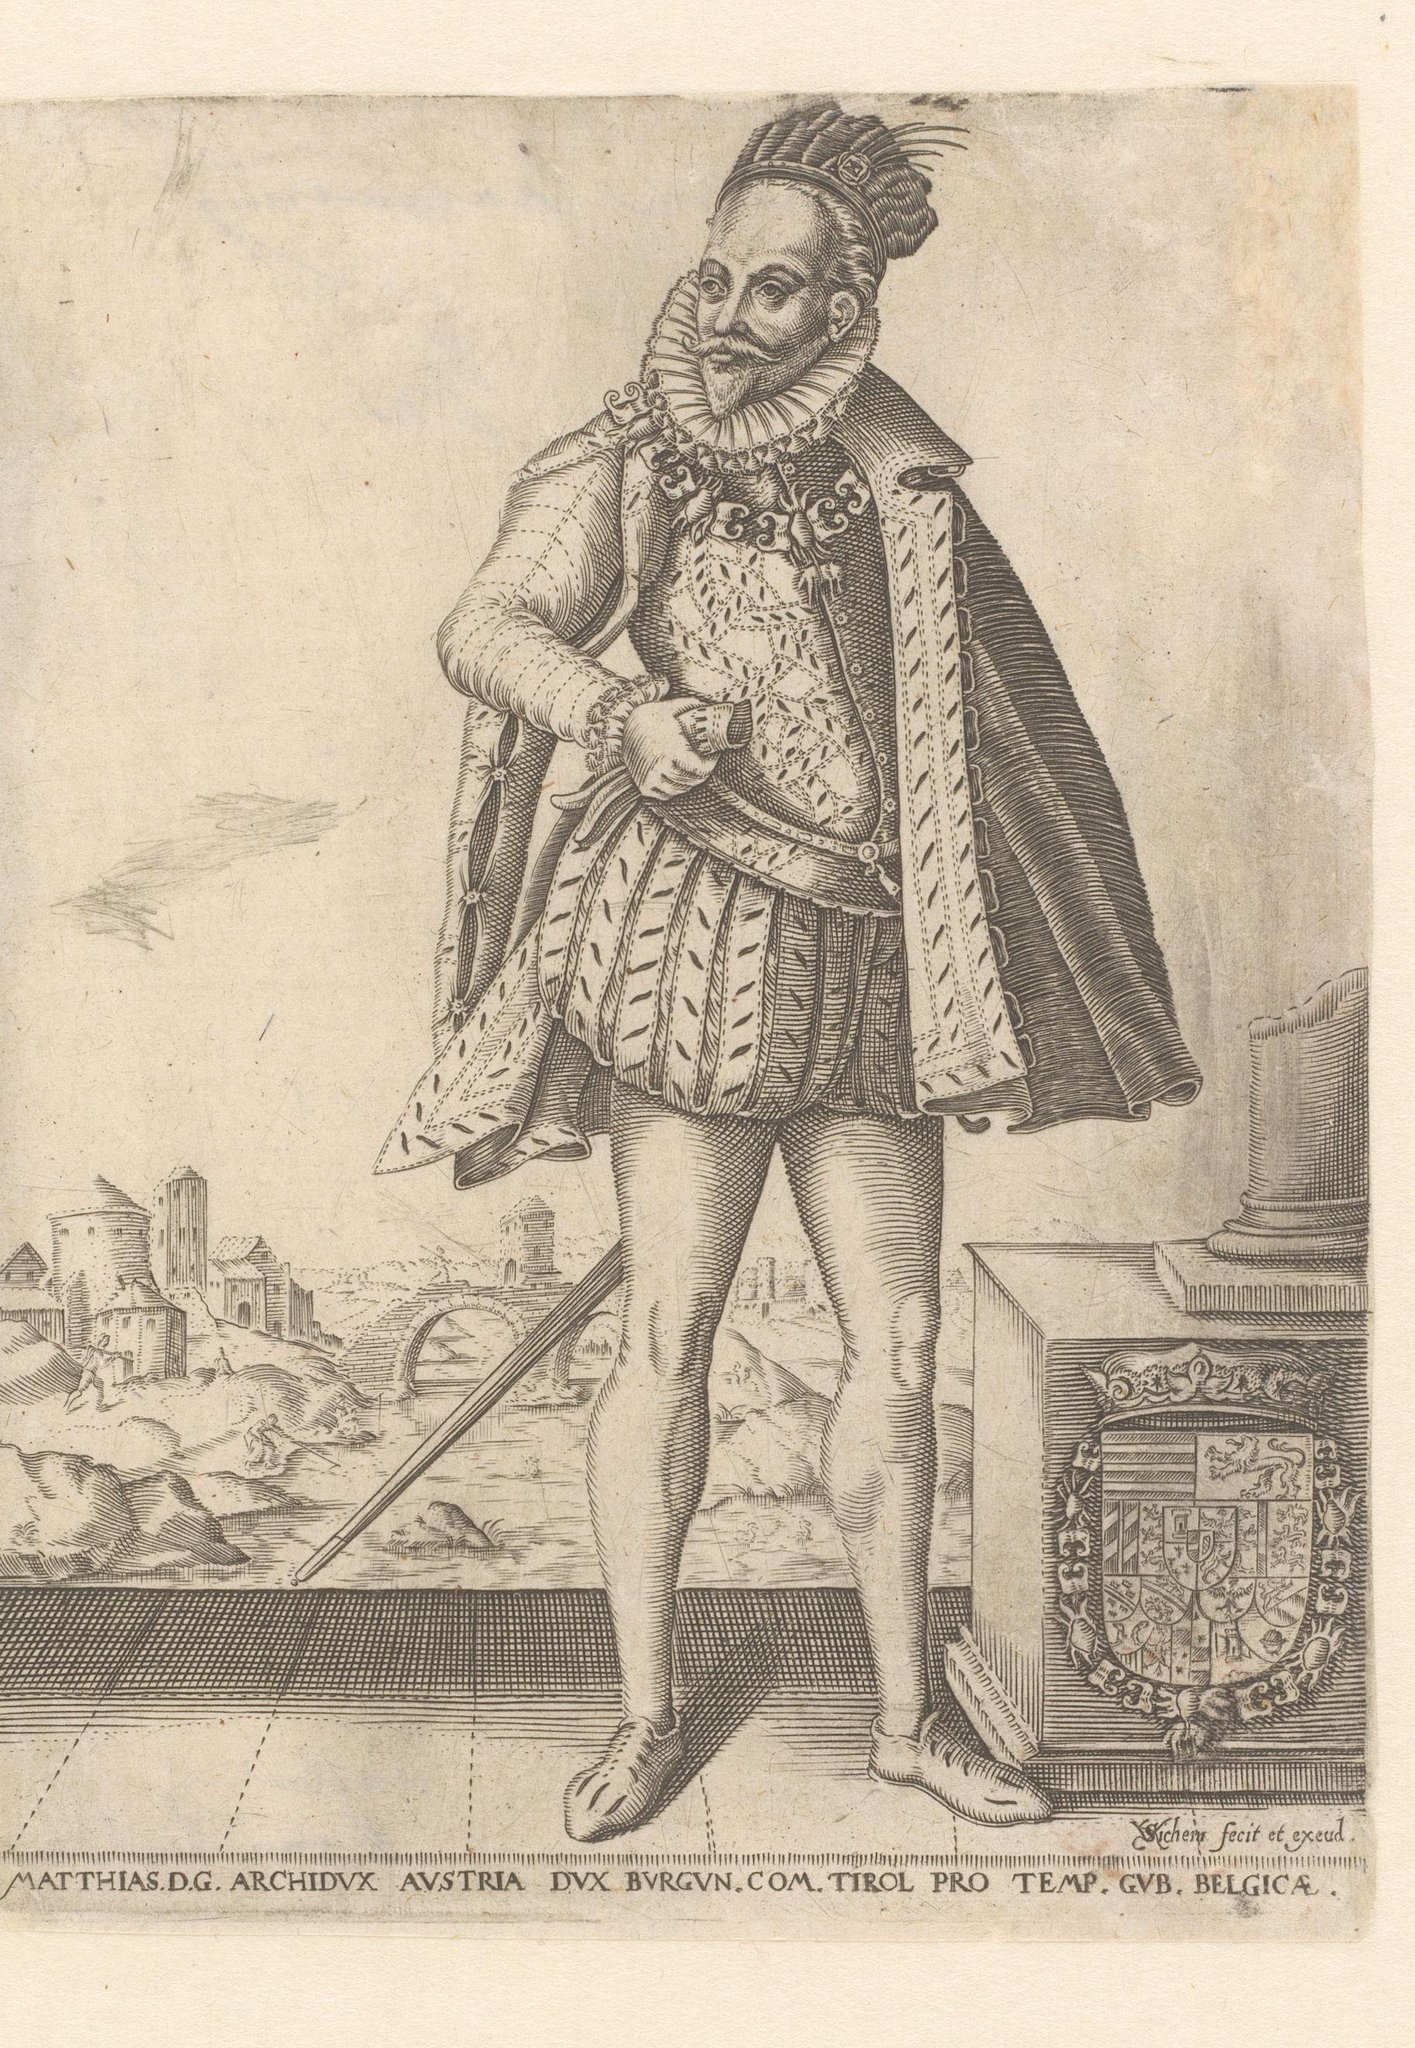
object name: print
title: Portret van keizer Matthias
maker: karel van sichem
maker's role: print maker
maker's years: 1575-1604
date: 1585-1604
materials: paper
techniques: engraving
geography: amsterdam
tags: vienna, matthias van oostenrijk (rooms-duits keizer), historical persons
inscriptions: collector's mark: Lugt 240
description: Van origine werd deze prent uitgegeven in een ornamentele lijst in houtsnede met tekst in boekdruk. De prent werd gebruikt voor: Meteren, E. van. Eigentlich und Volkomene Historische Beschreibung des Niederlendischen Krieges (...). Arnhem: Johan Janssen, 1614. De prent komt ook voor in: Meteren, E. van. Niederländische Historien oder Geschichten aller deren Handel (...). Arnhem: Jan Jansz., 1611. Prent komt ook voor in: Reyd, E. van. Voornaemste Geschiedenissen in de Nederlanden ende elders (...). Arnhem: s.n., 1626.